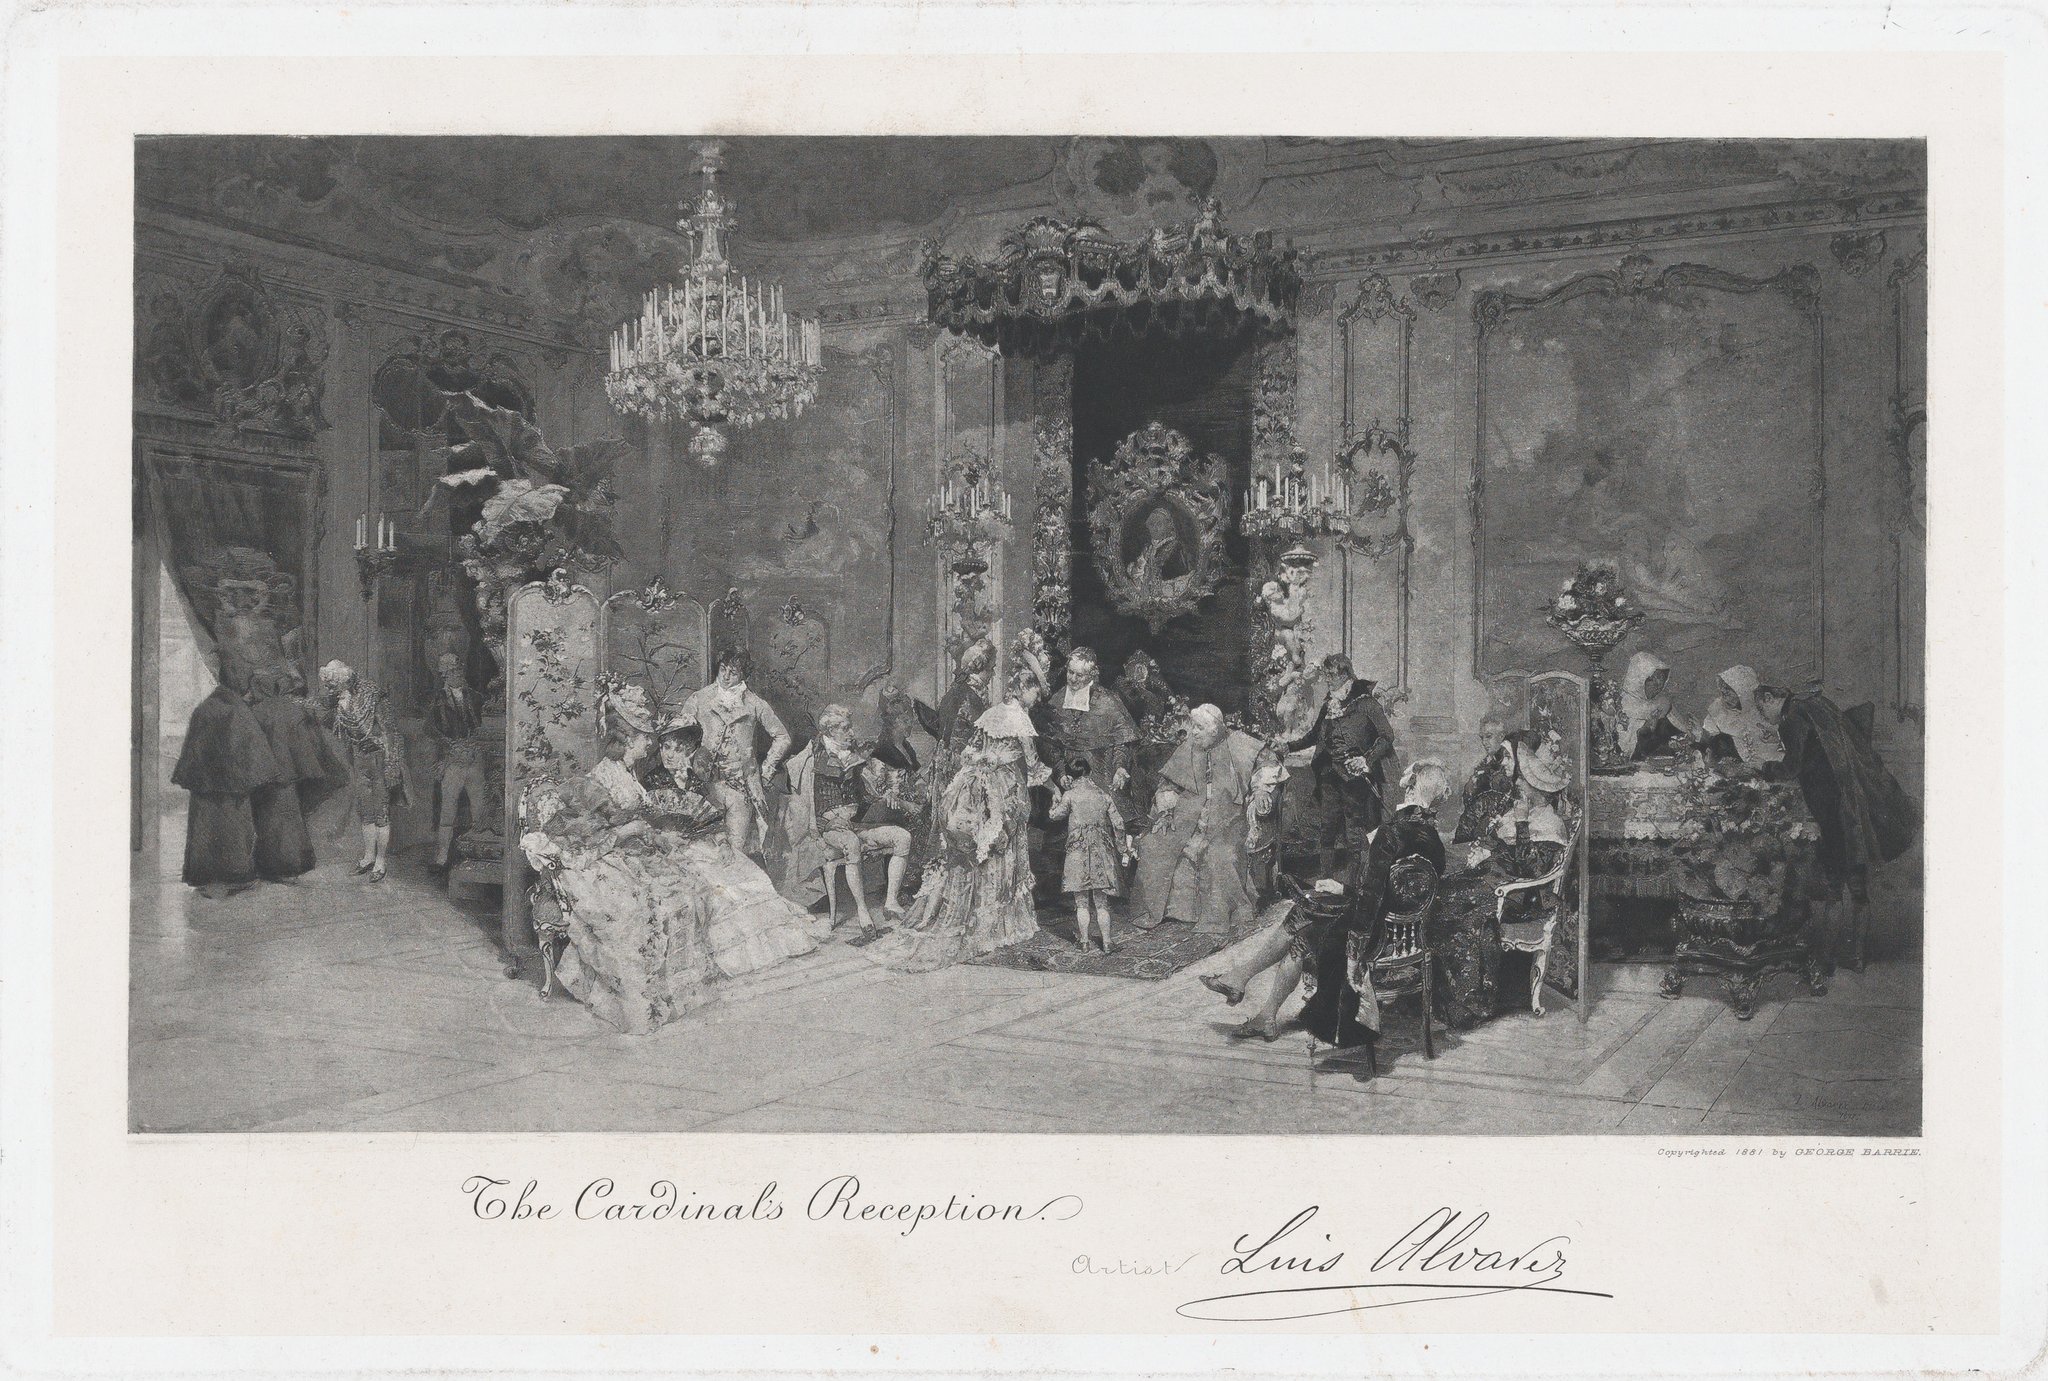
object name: print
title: The Cardinal's Reception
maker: luis alvarez catalá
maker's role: artist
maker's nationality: spanish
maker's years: 1836-1901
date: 1881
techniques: printmaking, photogravure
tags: men,women,party